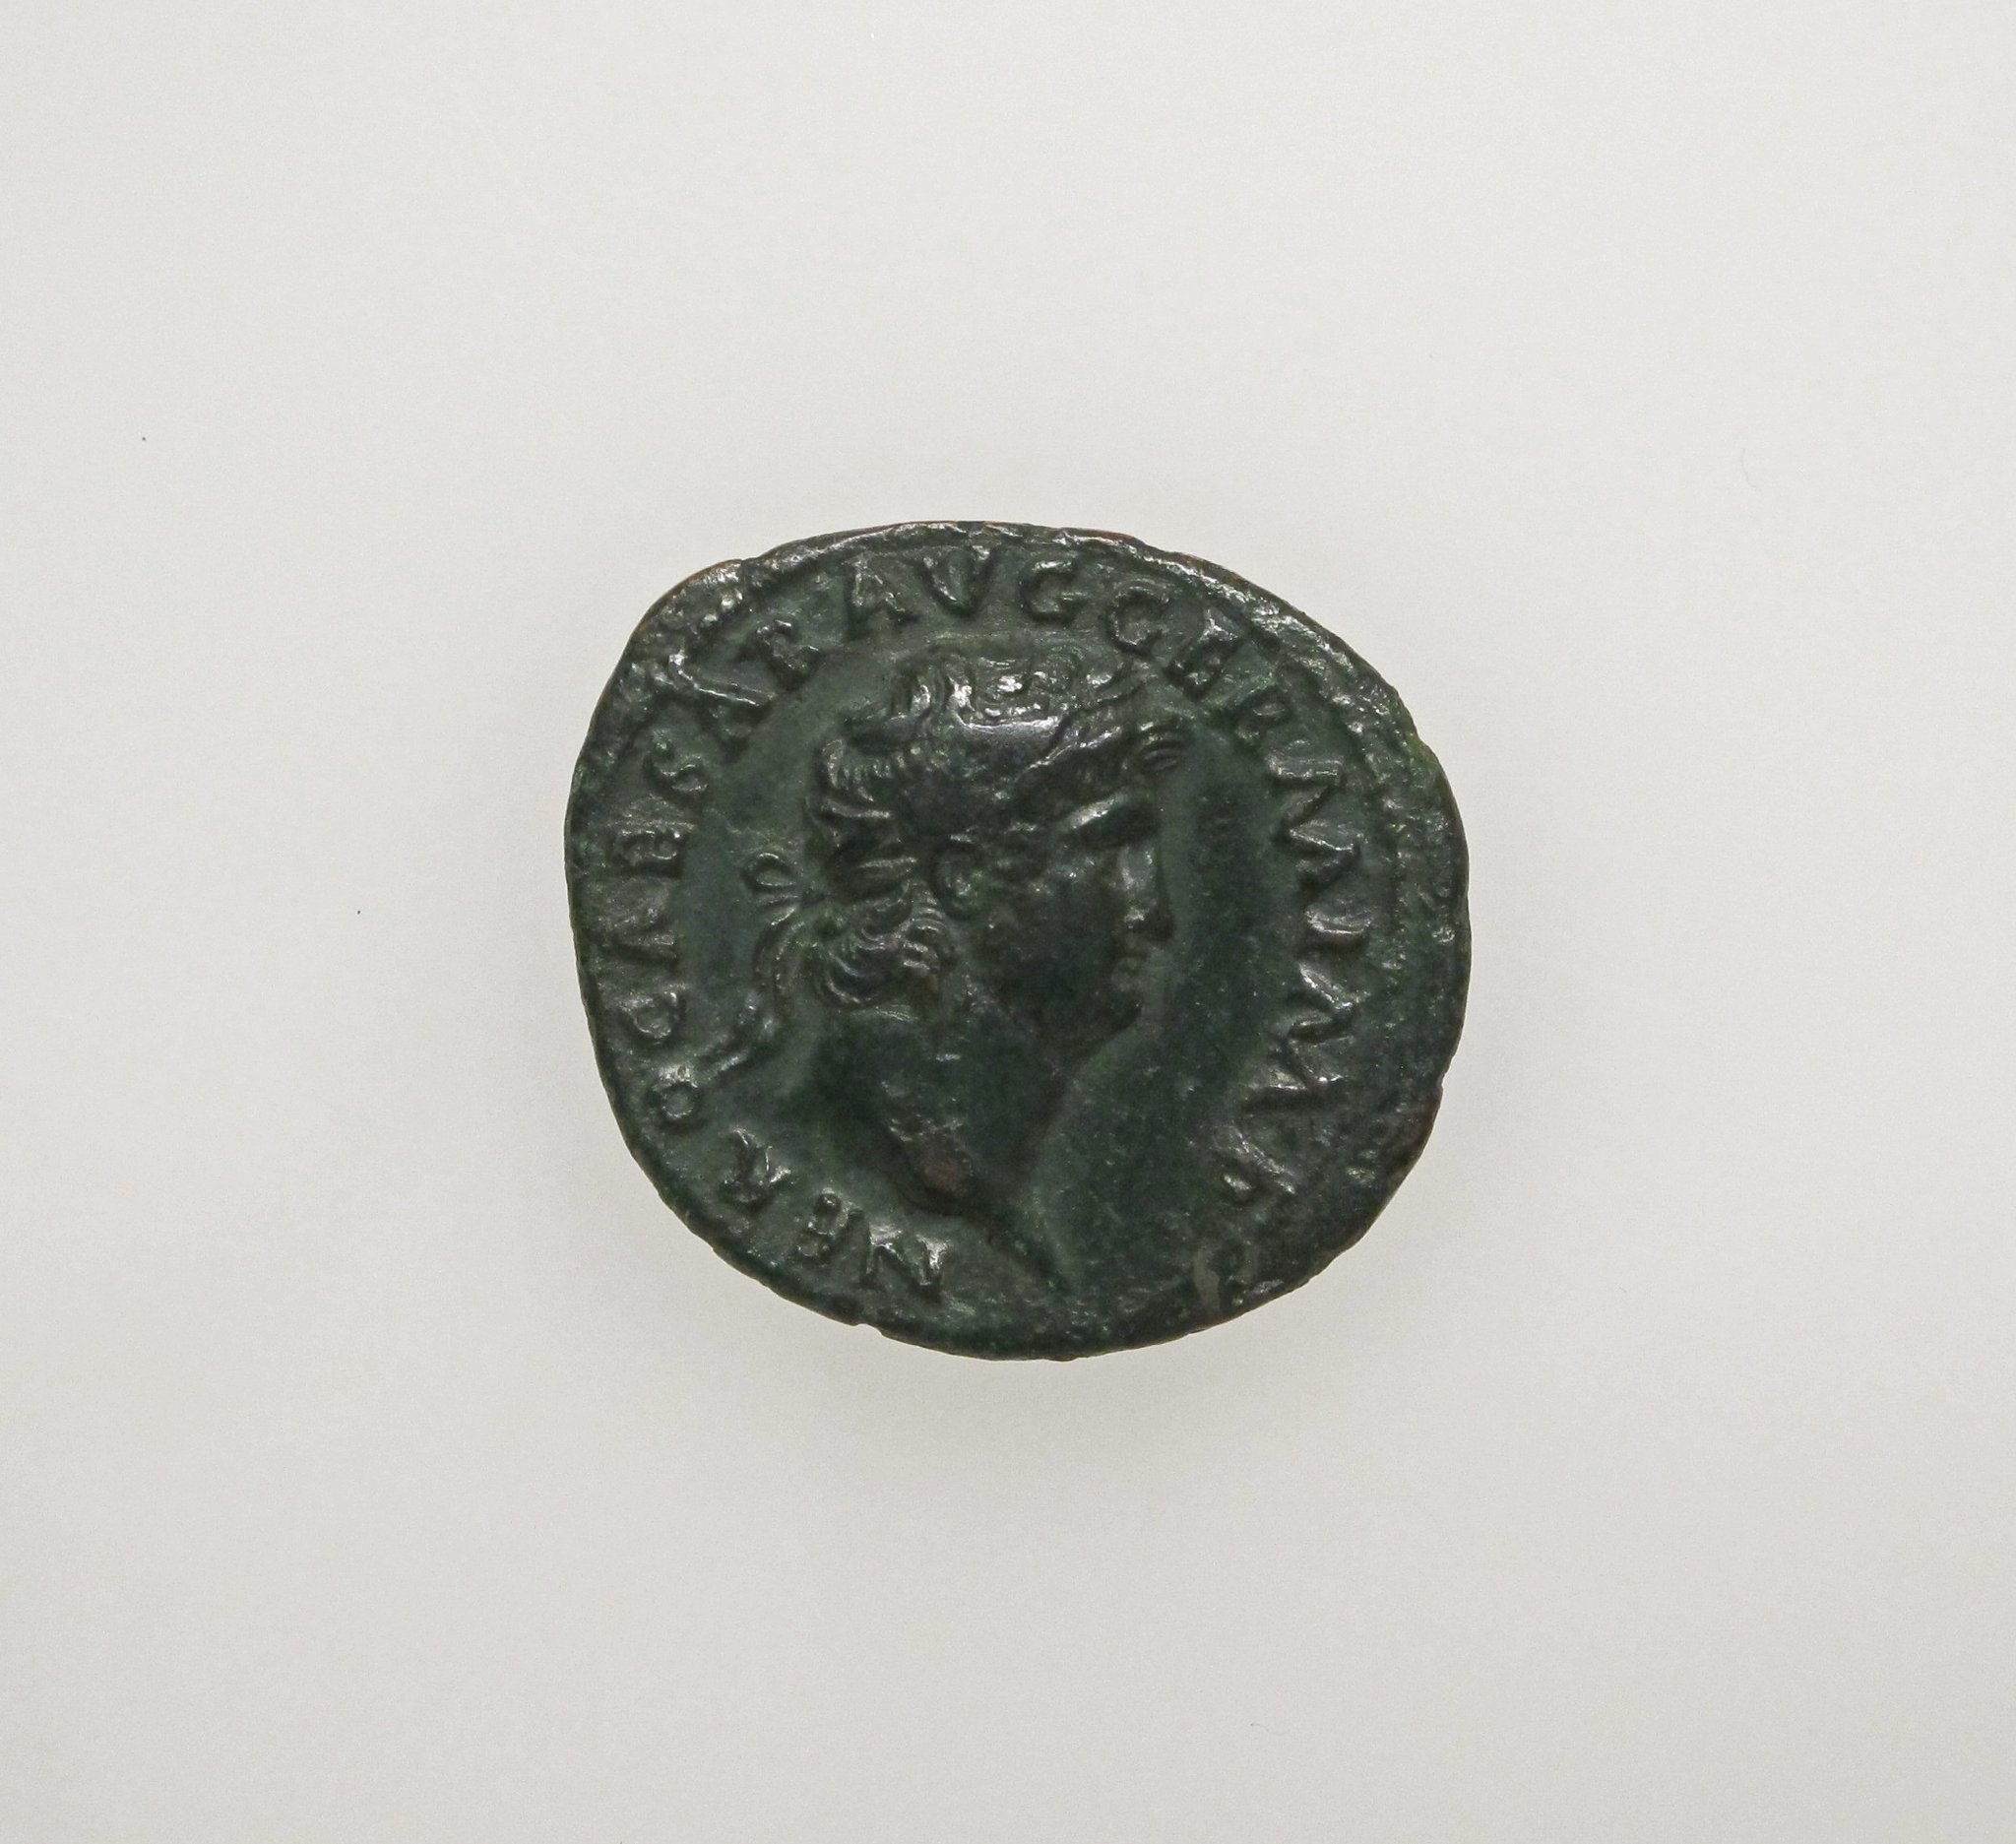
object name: a of nero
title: Bronze as of Nero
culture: roman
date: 64-66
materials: bronze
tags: nero,profiles